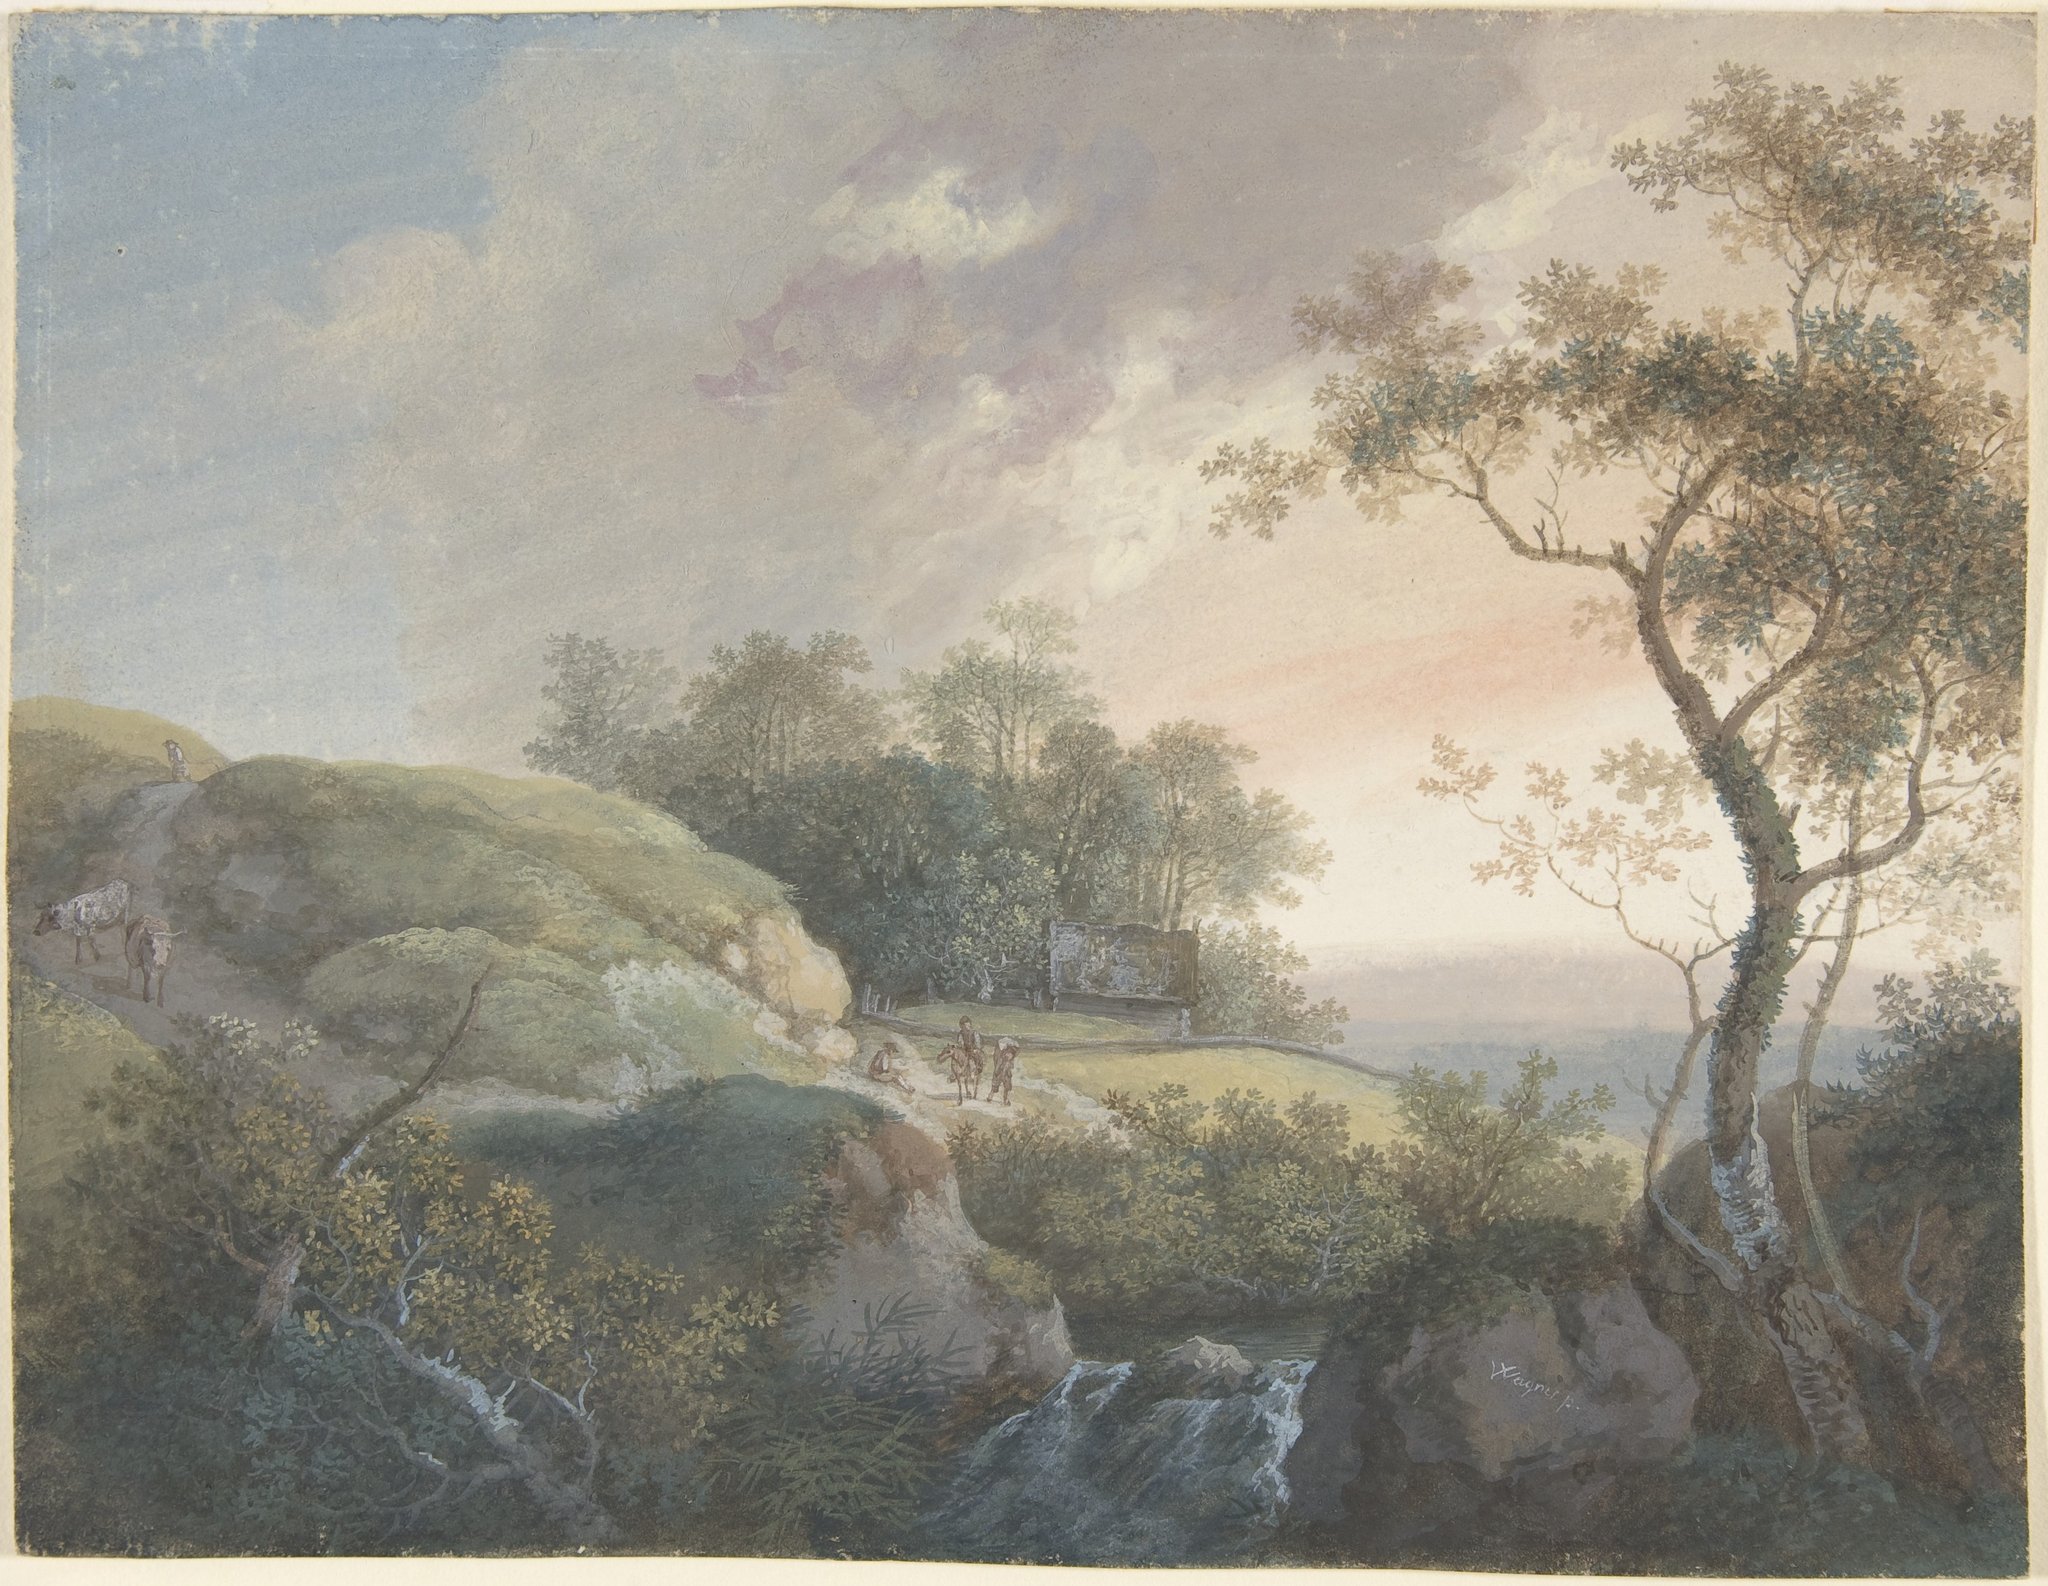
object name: drawing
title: The Morning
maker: johann georg wagner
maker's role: artist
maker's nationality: german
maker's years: 1732-1767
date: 1732-1767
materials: gouache, watercolor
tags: animals,landscapes,trees,morning